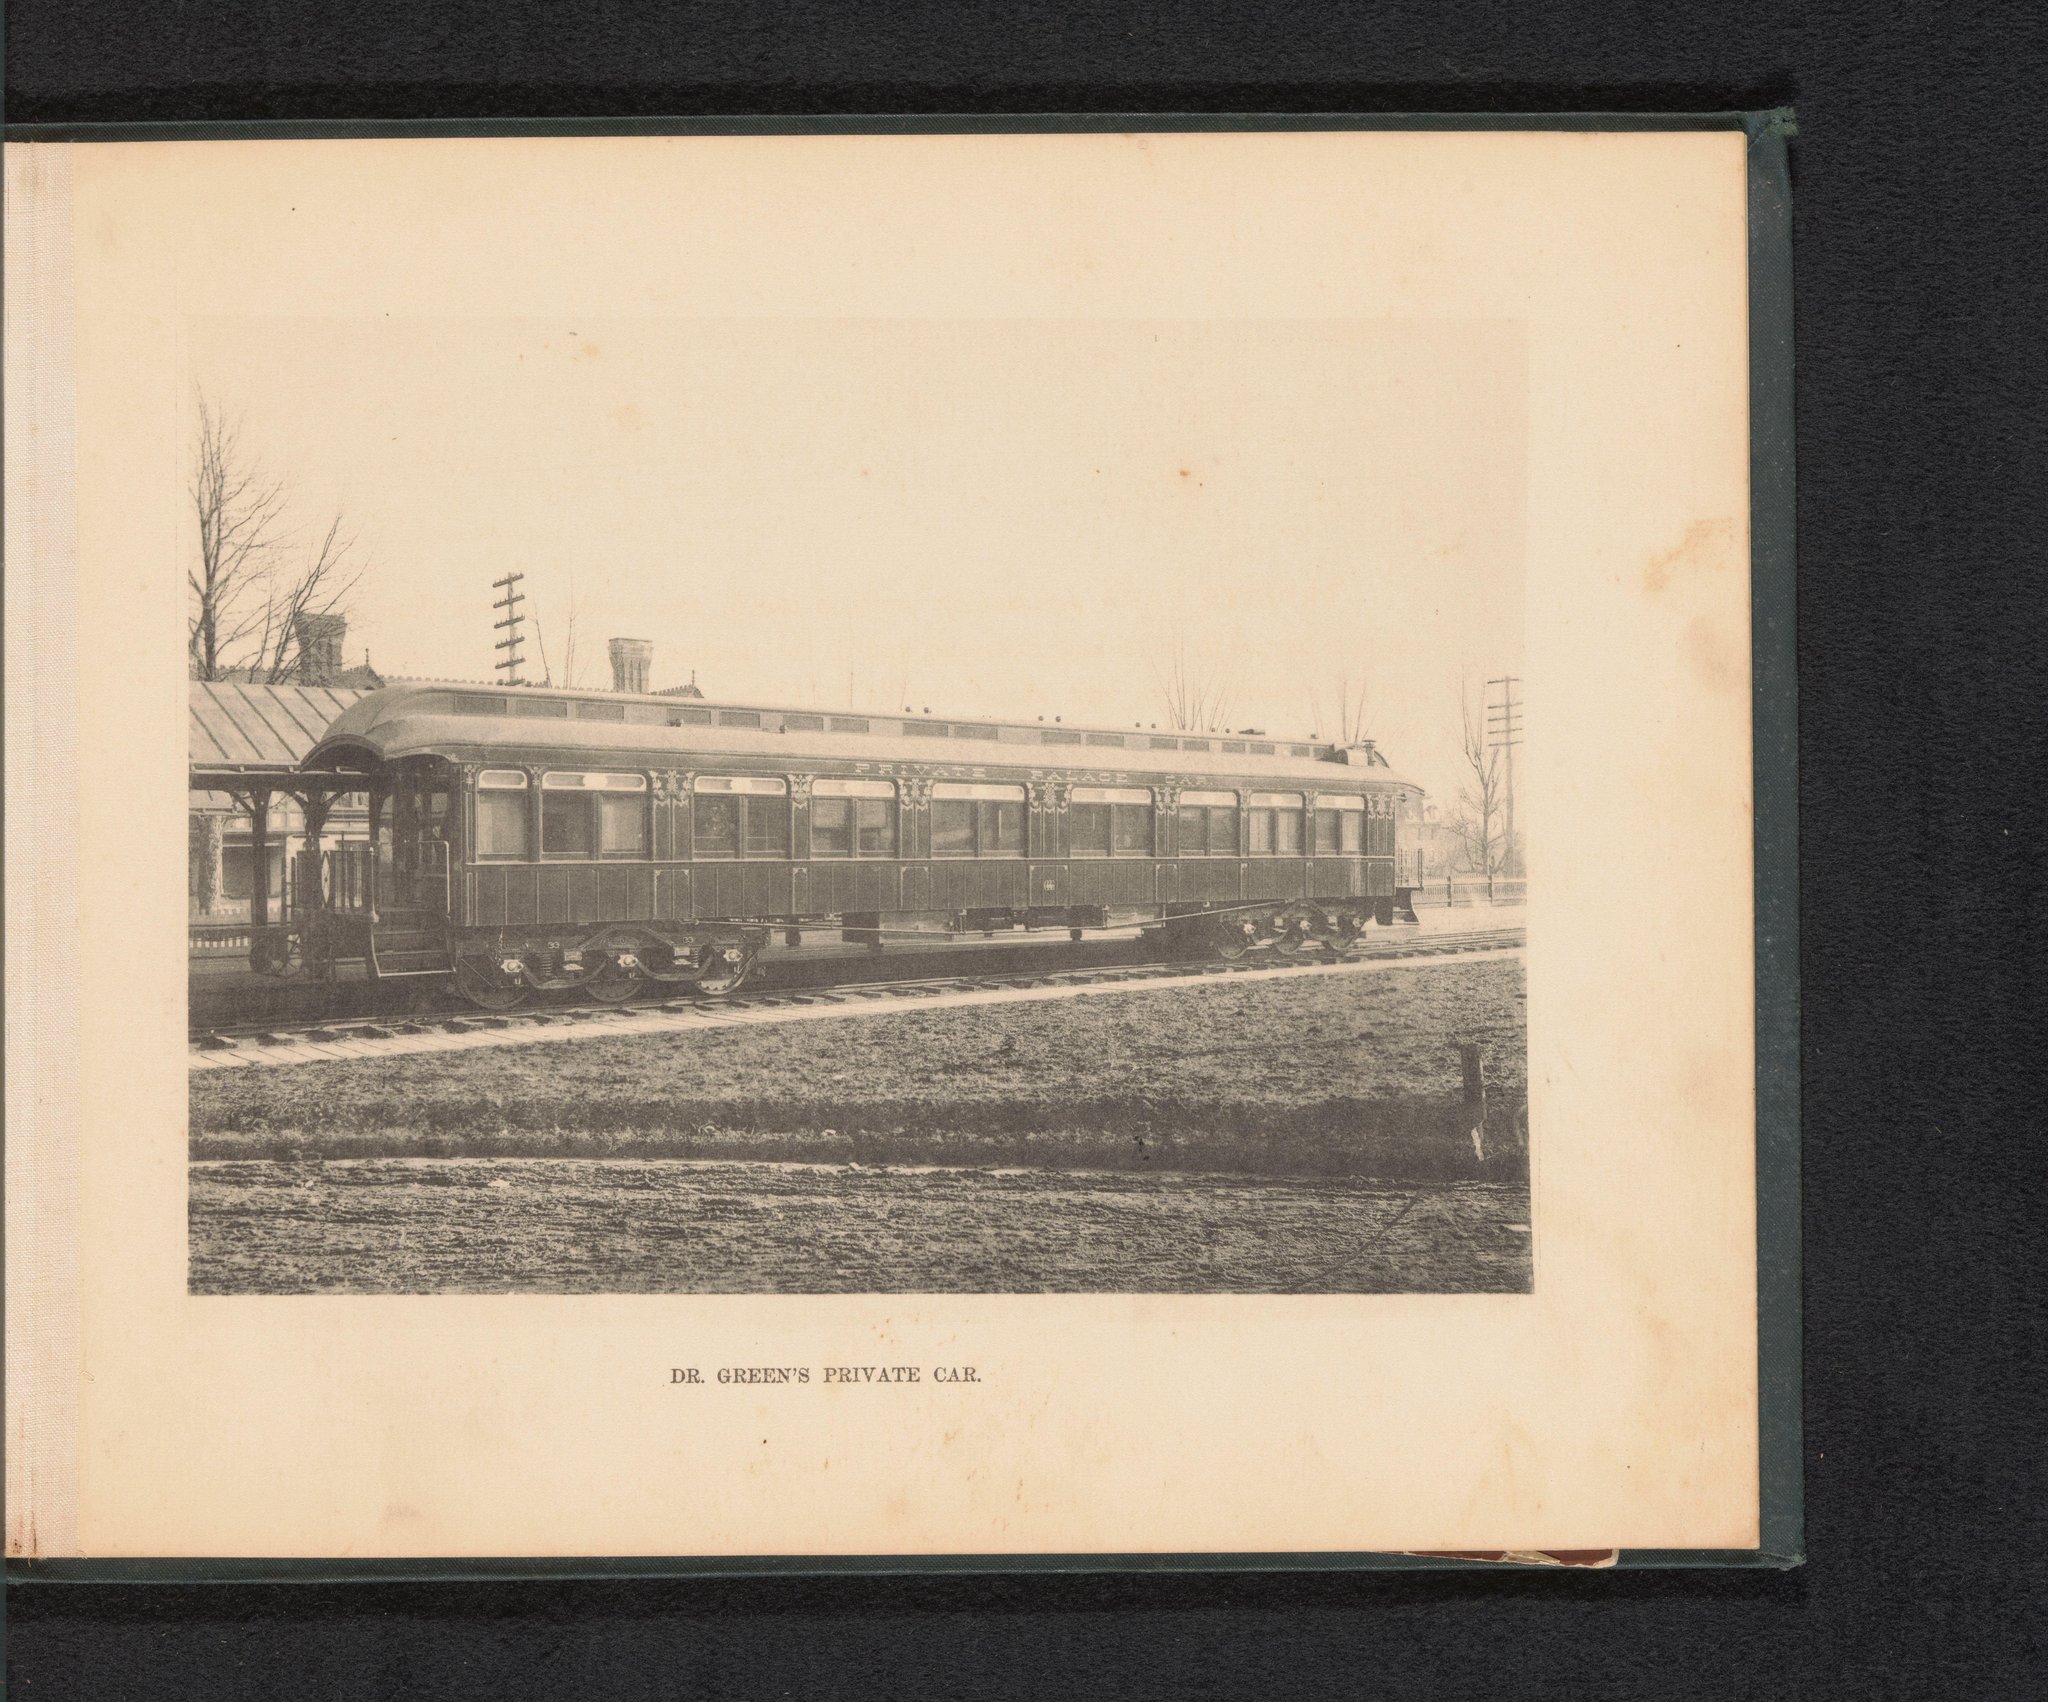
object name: photomechanical print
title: Treinwagon van George Gill Green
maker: Anonymous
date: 1879-1889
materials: paper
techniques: photograph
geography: woodbury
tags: railway wagon